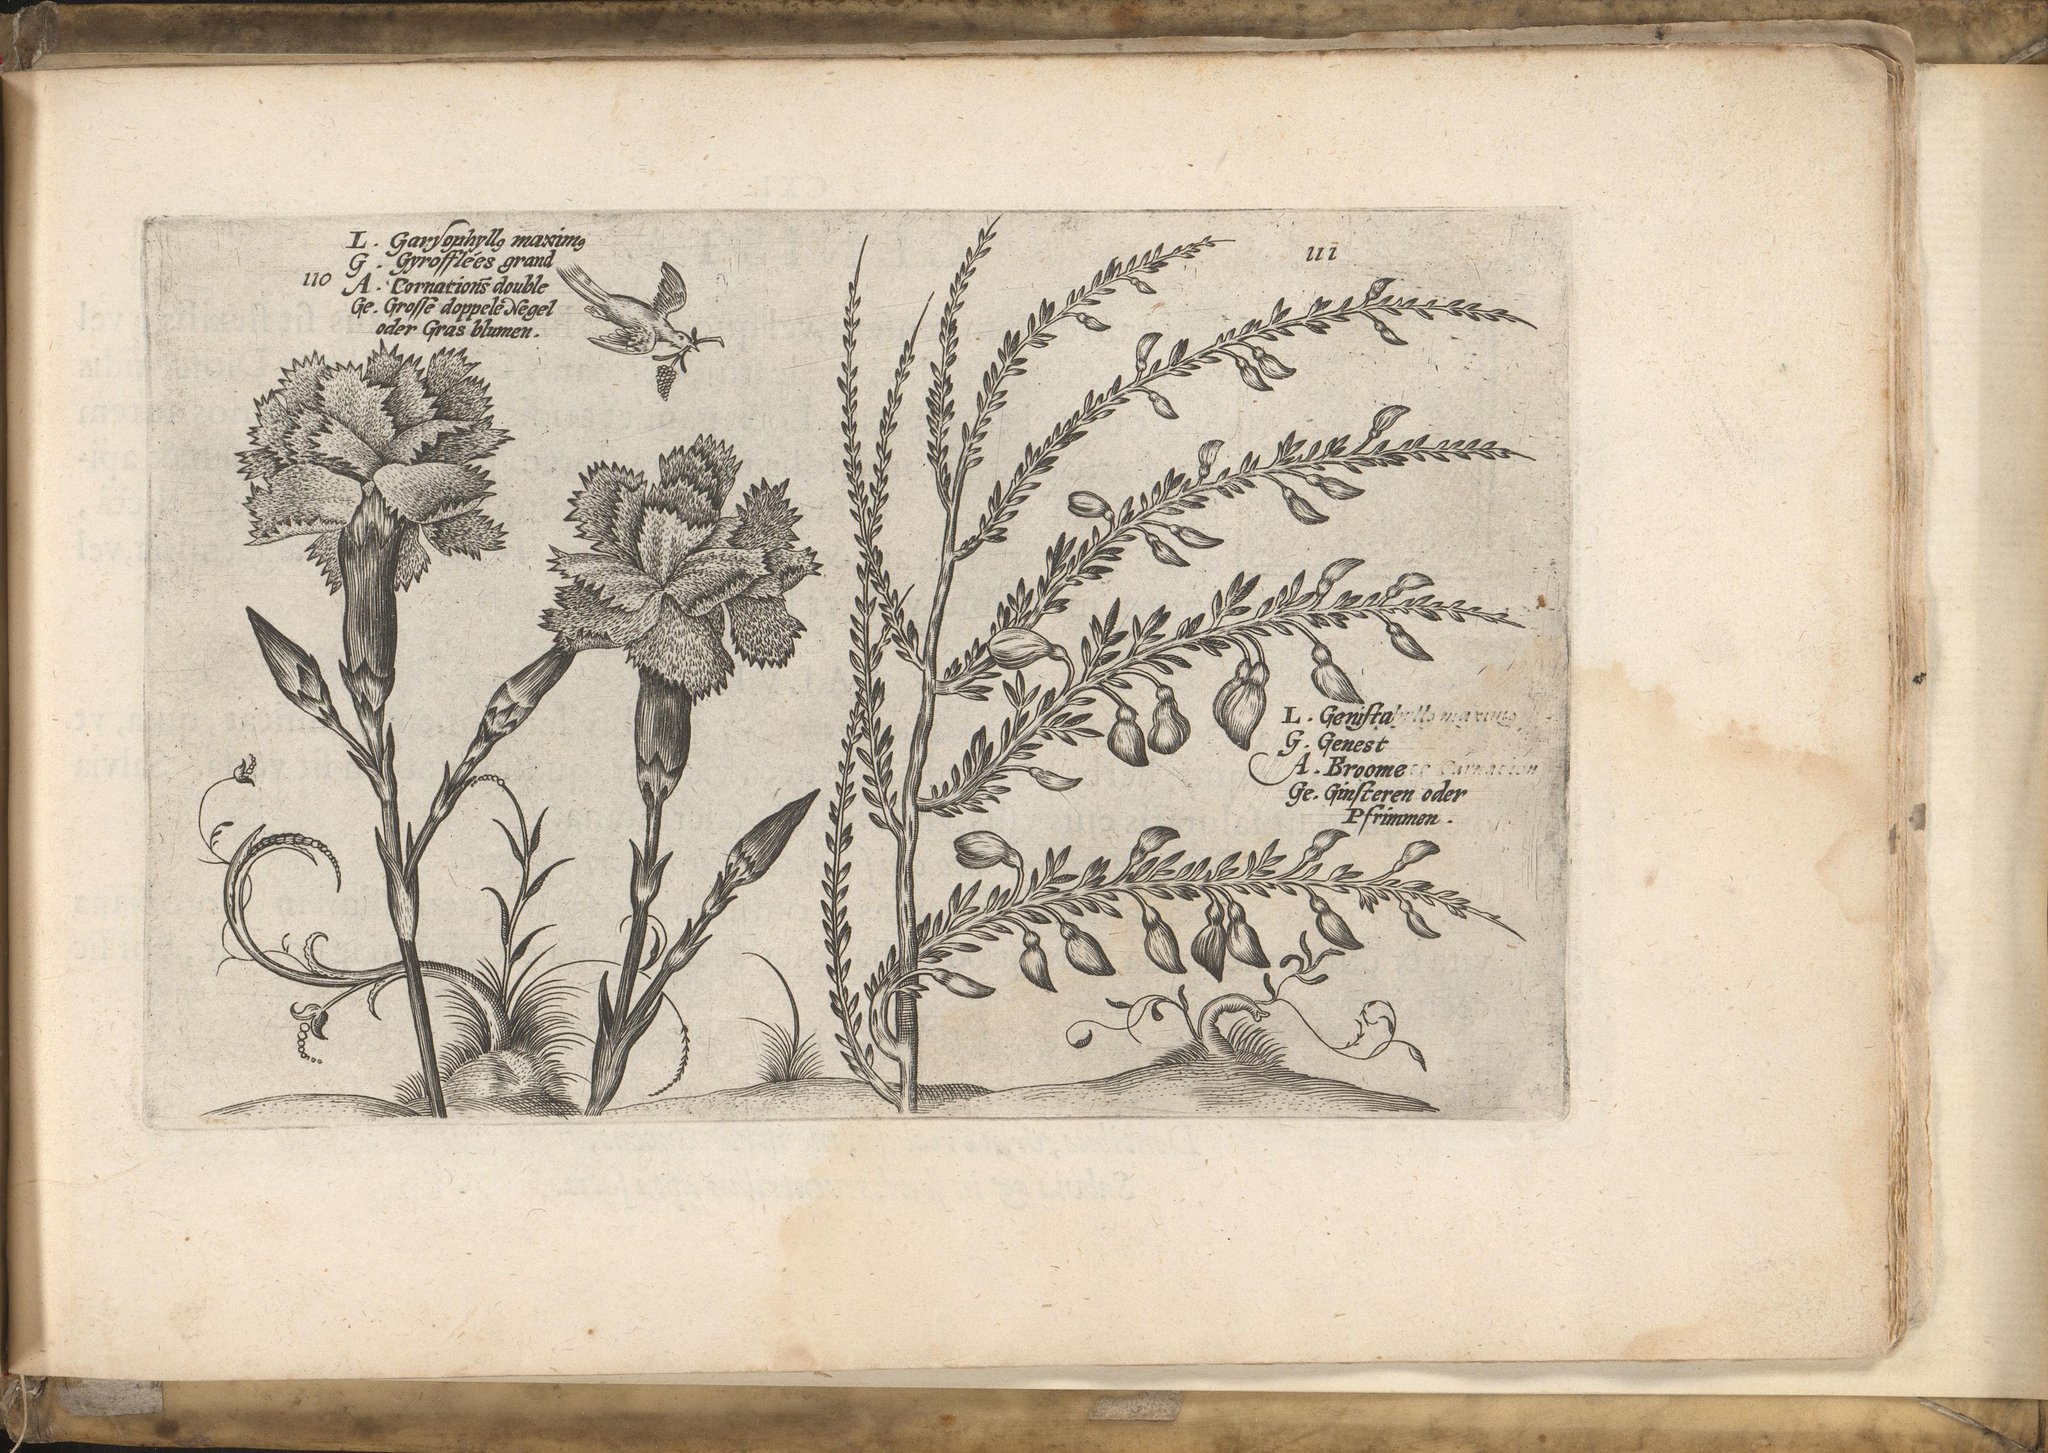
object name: book illustration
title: Bloementuin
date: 1617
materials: paper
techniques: engraving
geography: arnhem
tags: flowers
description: Prent uit: Passe, Crispijn van de (II). Hortus floridus in quo rariorum & minus vulgarium florum icones ad vivam veramque formam. Arnhem: Johannes Janssonius, 1617.